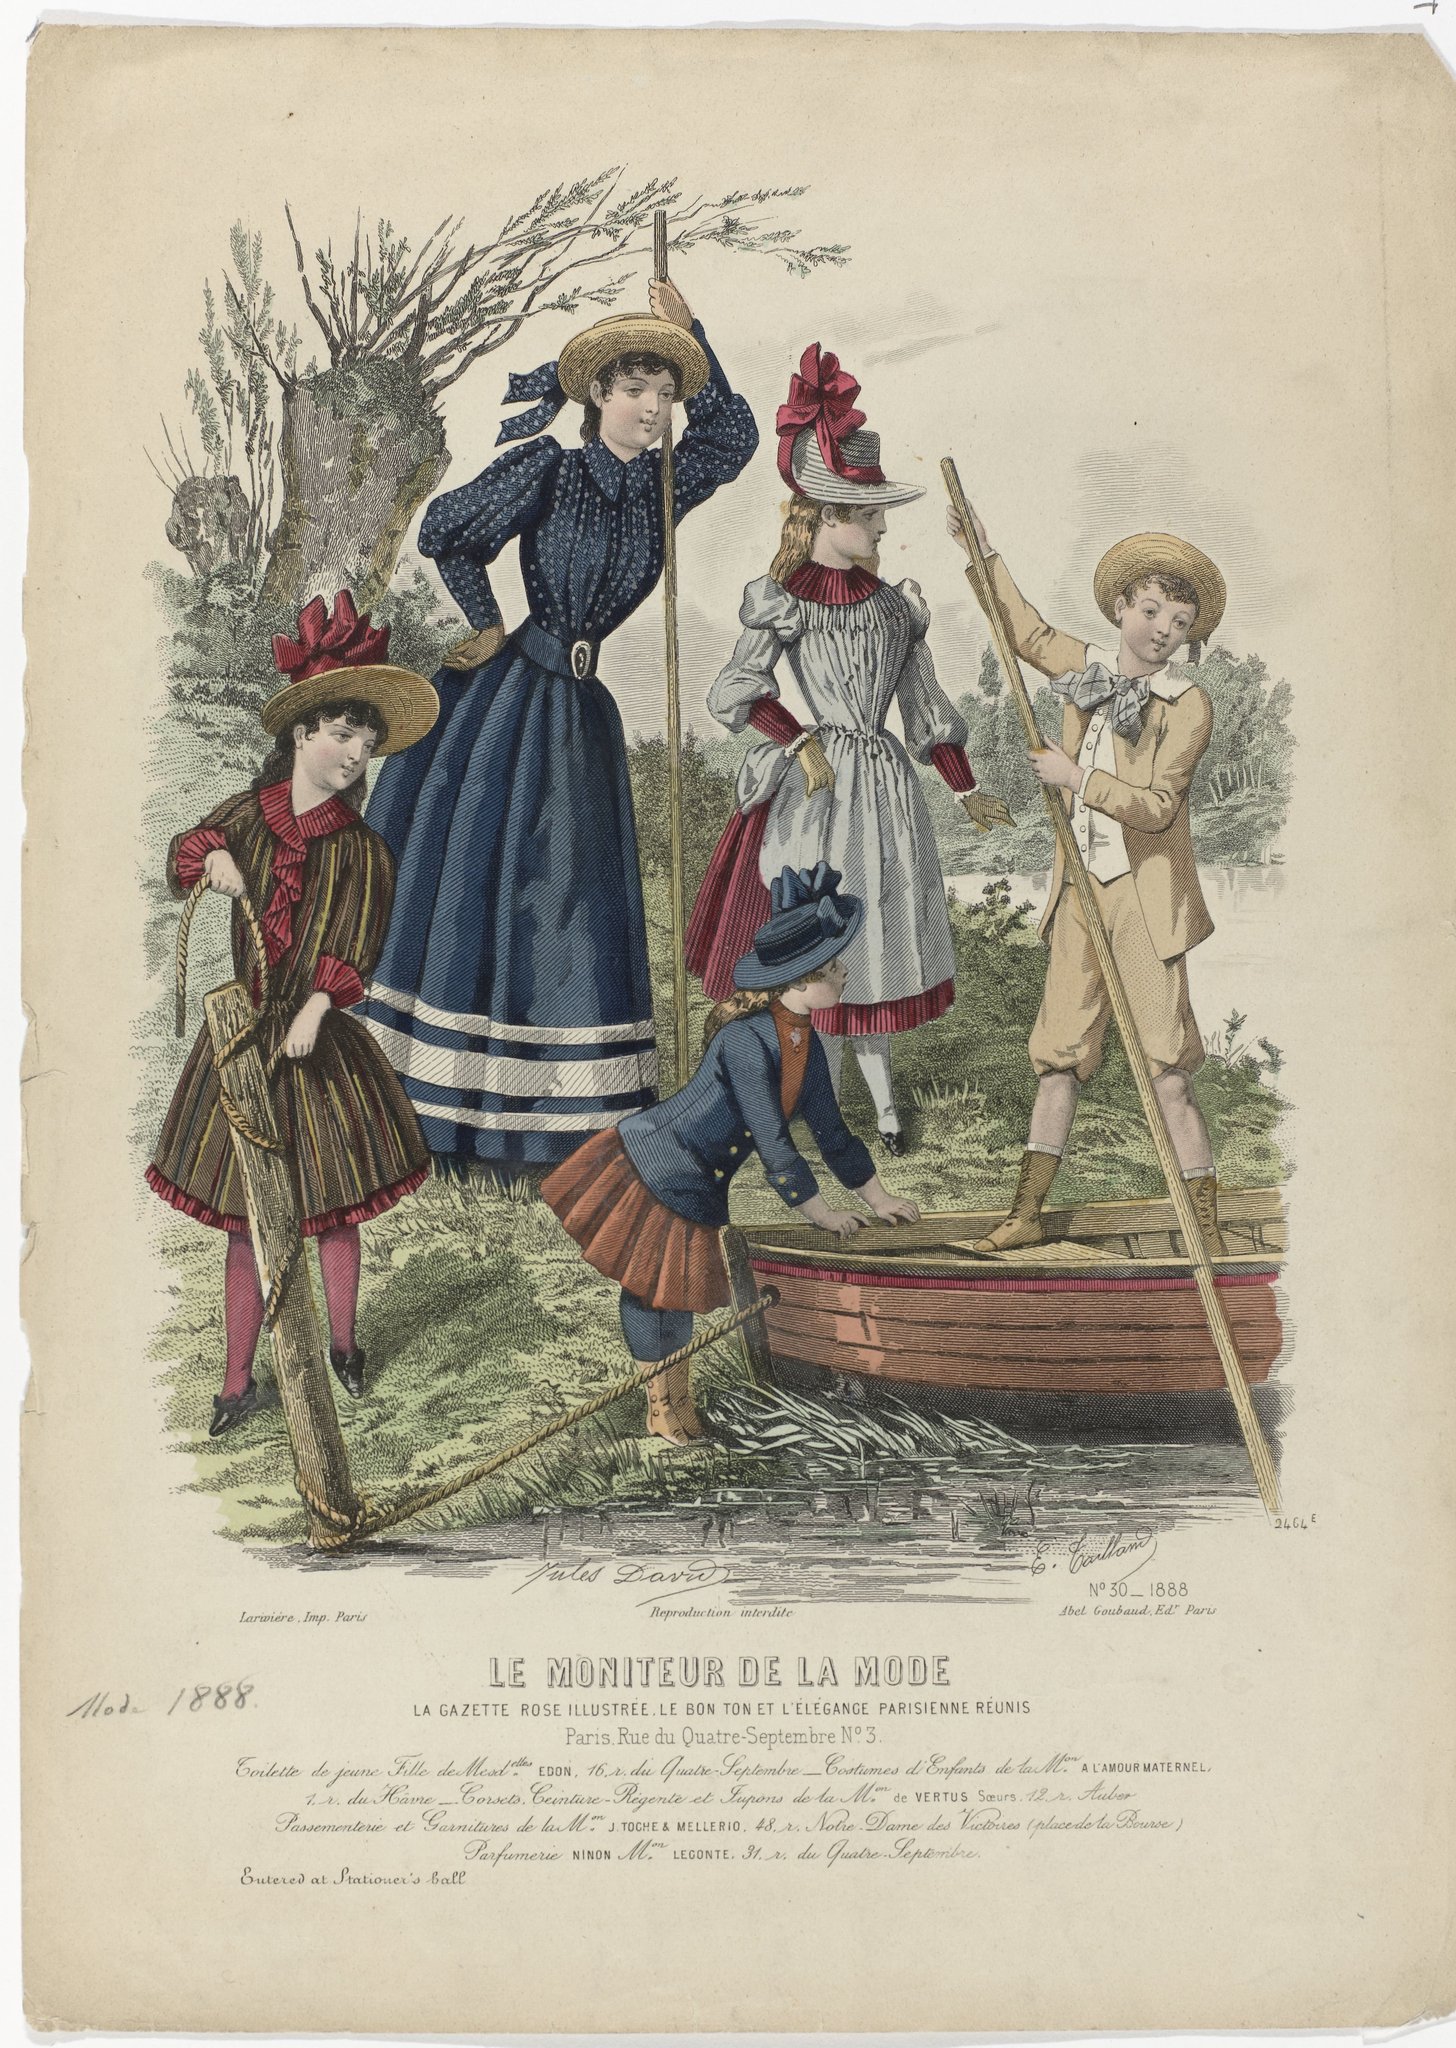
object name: fashion print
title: Le Moniteur de la Mode, 1888, Nr. 2464e, No. 30 : Toilette de jeune Fill (...)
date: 1888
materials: paper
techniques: engraving, hand coloring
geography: paris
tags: clothing for the upper part of the body: blouse (+ women's clothes), head-gear: hat (+ girls' clothes), trousers, breeches (+ boys' clothes), neck-gear ~ clothing (+ boys' clothes), coat (+ boys' clothes), fashion plates, head-gear: hat (+ women's clothes), skirt (+ women's clothes), poling, punting, dress, gown (+ girls' clothes)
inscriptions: caption: ‘Toilette de jeun Fille de Mesd.elles EDON, 16,r, du Quatre-Septembre_ Costumes d'Enfants de la Mon A L'AMOUR MATERNEL, 1,r, du Hâvre _ Corsets, Ceinture- Régente et Jupons de la Mon de VERTUS Soeurs,12,r, Auber Passementerie et Garnitures de la Mon J.TOCHE & MELLERIO,48,r, Notre- Dame des Victoires (Place de la Bourse) Parfumerie NINON Mon LECONTE, 31, r, du Quatre- Septembre. / Entered at Stationer's hall’, address: ‘Paris, Rue du Quatre-Septembre, No. 3’, title: ‘LE MONITEUR DE LA MODE / LA GAZETTE ROSE ILLUSTRÉE, LE BON TON ET L'ÉLÉGANCE PARISIENNE RÉUNIS’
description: Vier meisjes en een jongen aan de waterkant bij een roeiboot; een meisje is bezig het touw om de meerpaal los te maken. Twee hebben een vaarboom vast. Volgens het onderschrift: jonge vrouw in een 'toilette' van Edon. Kinderkleding van A L'Amour Maternel. Hieronder enkele regels reclametekst voor verschillende producten. Prent uit het modetijdschrift Le Moniteur de la Mode (1843-1913).